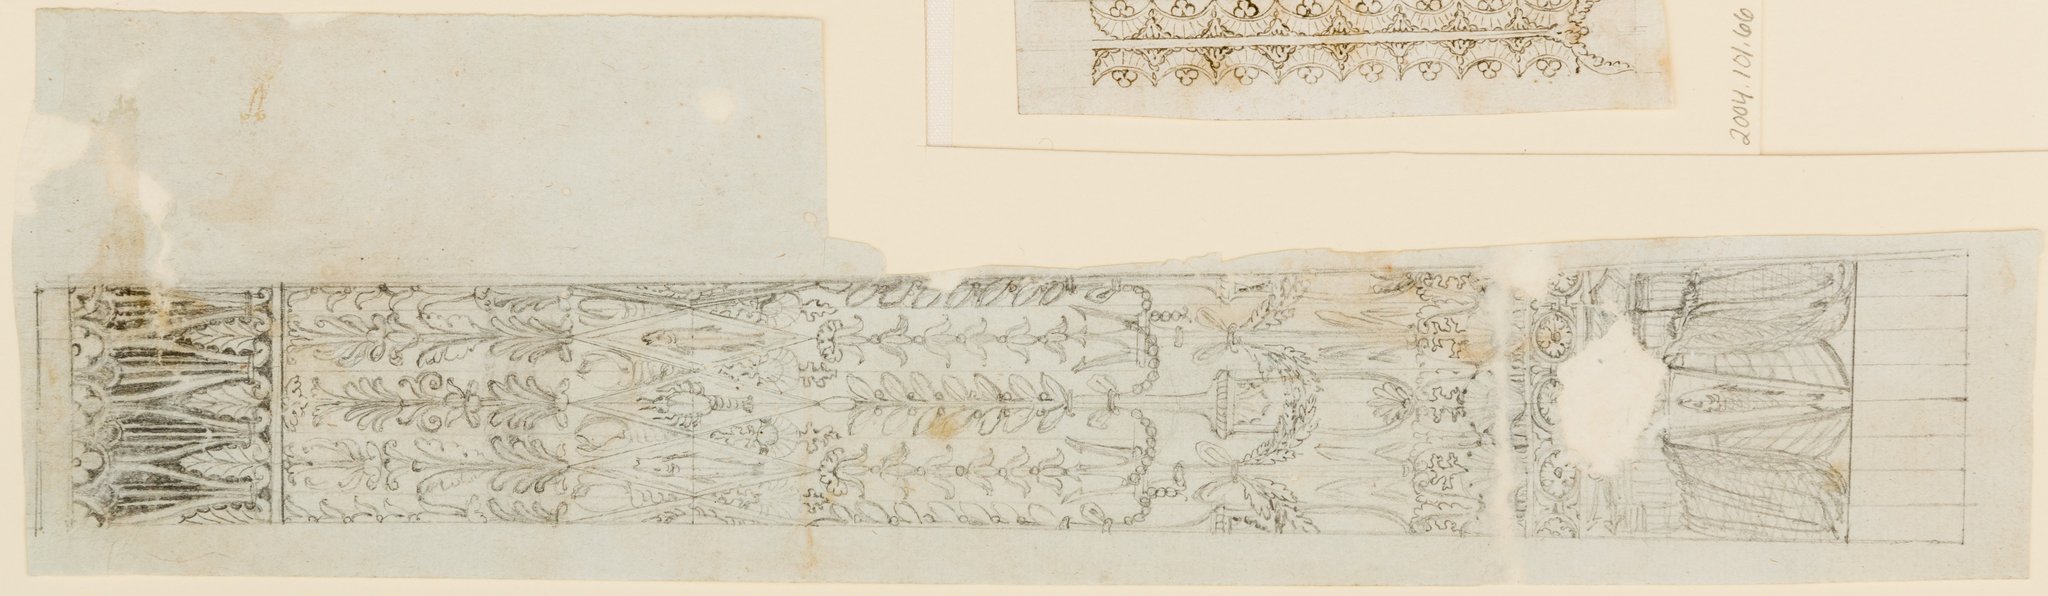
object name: drawing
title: Design for the Decoration of the Barrel of a Firearm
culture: french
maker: nicolas noël boutet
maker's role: designer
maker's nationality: french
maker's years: 1761-1833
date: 1797-1805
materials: ink, paper, pencil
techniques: wash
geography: france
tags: ornament